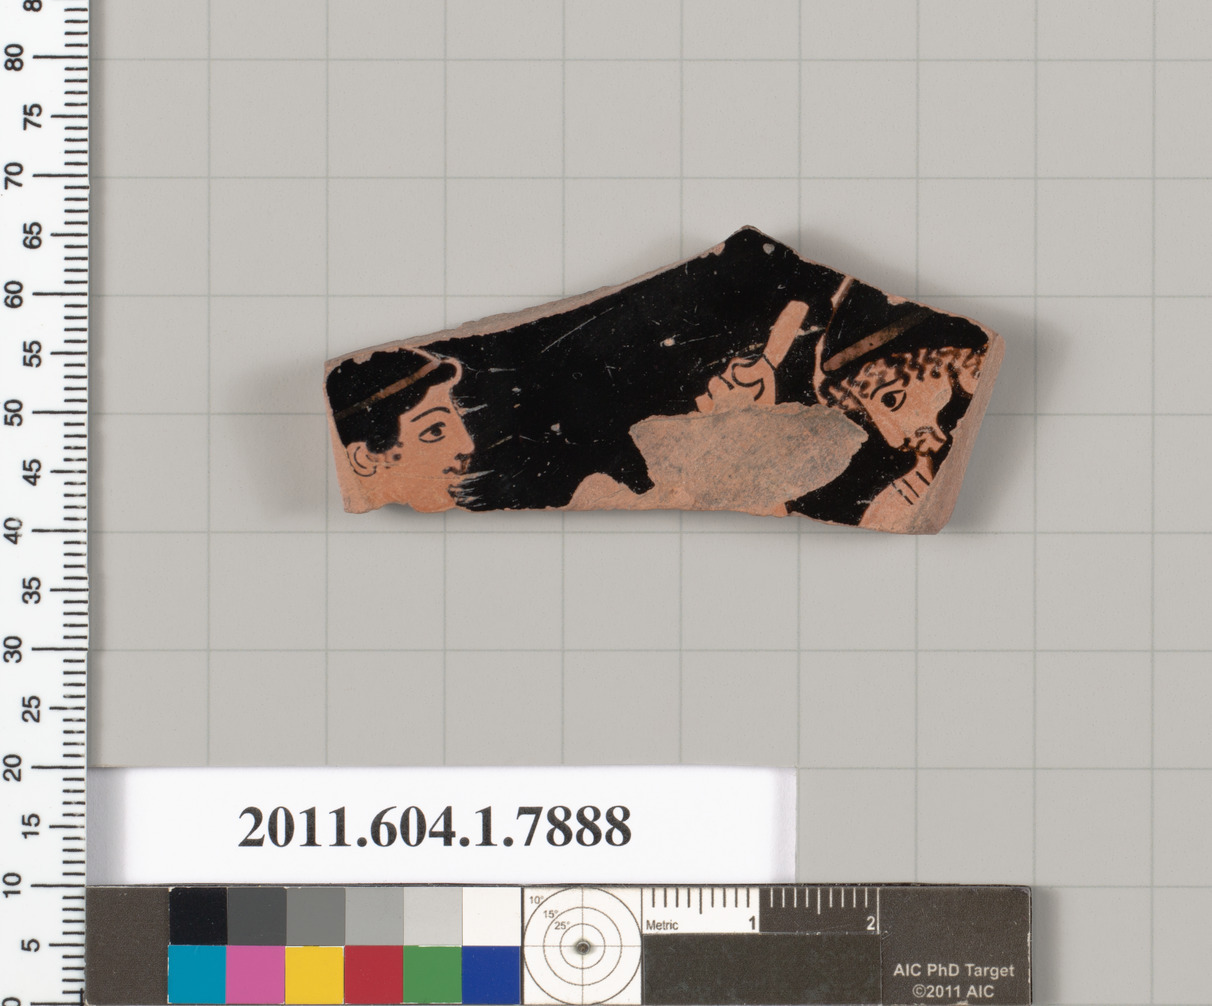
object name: kylix fragment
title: Terracotta fragment of a kylix (drinking cup)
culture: greek, attic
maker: boot painter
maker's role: artist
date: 480-460 BCE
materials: terracotta